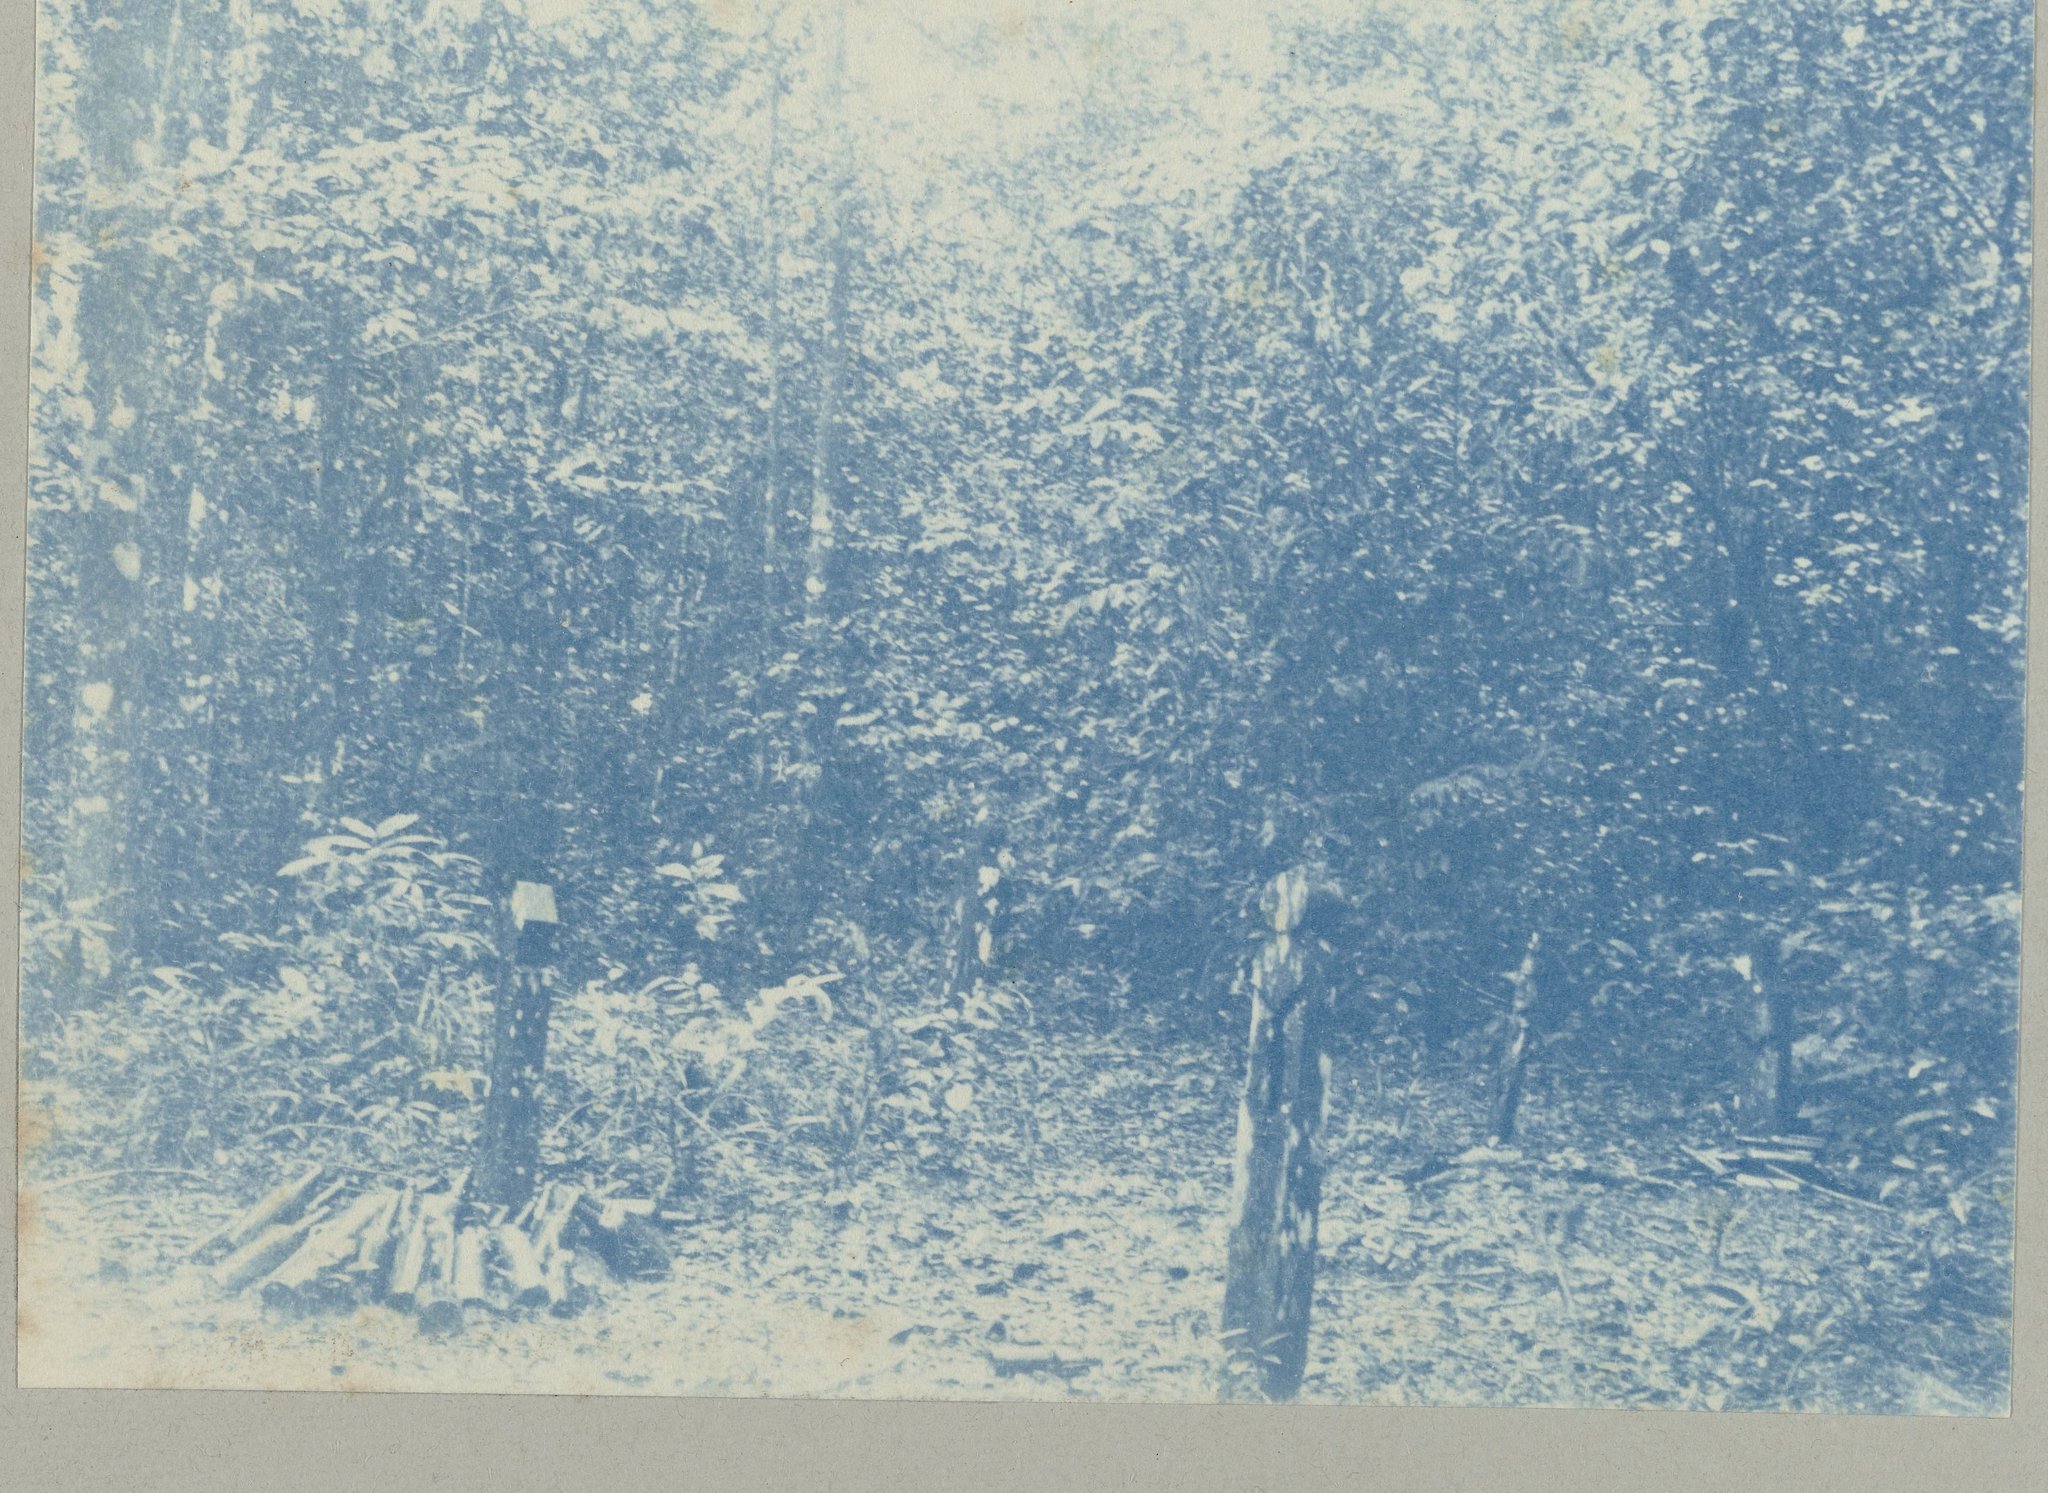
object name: photograph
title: Begraafplaats te Berlijn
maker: hendrik doijer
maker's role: engineer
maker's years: 1863-1925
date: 1903-1910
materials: photographic support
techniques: cyanotype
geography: suriname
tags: suriname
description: Lokale begraafplaats te Berlijn in Suriname, houten staken in de grond markeren de graven. Onderdeel van het fotoalbum Souvenir de Voyage (deel 2), over het leven van de familie Doijer in en rond de plantage Ma Retraite in Suriname in de jaren 1903-1910.